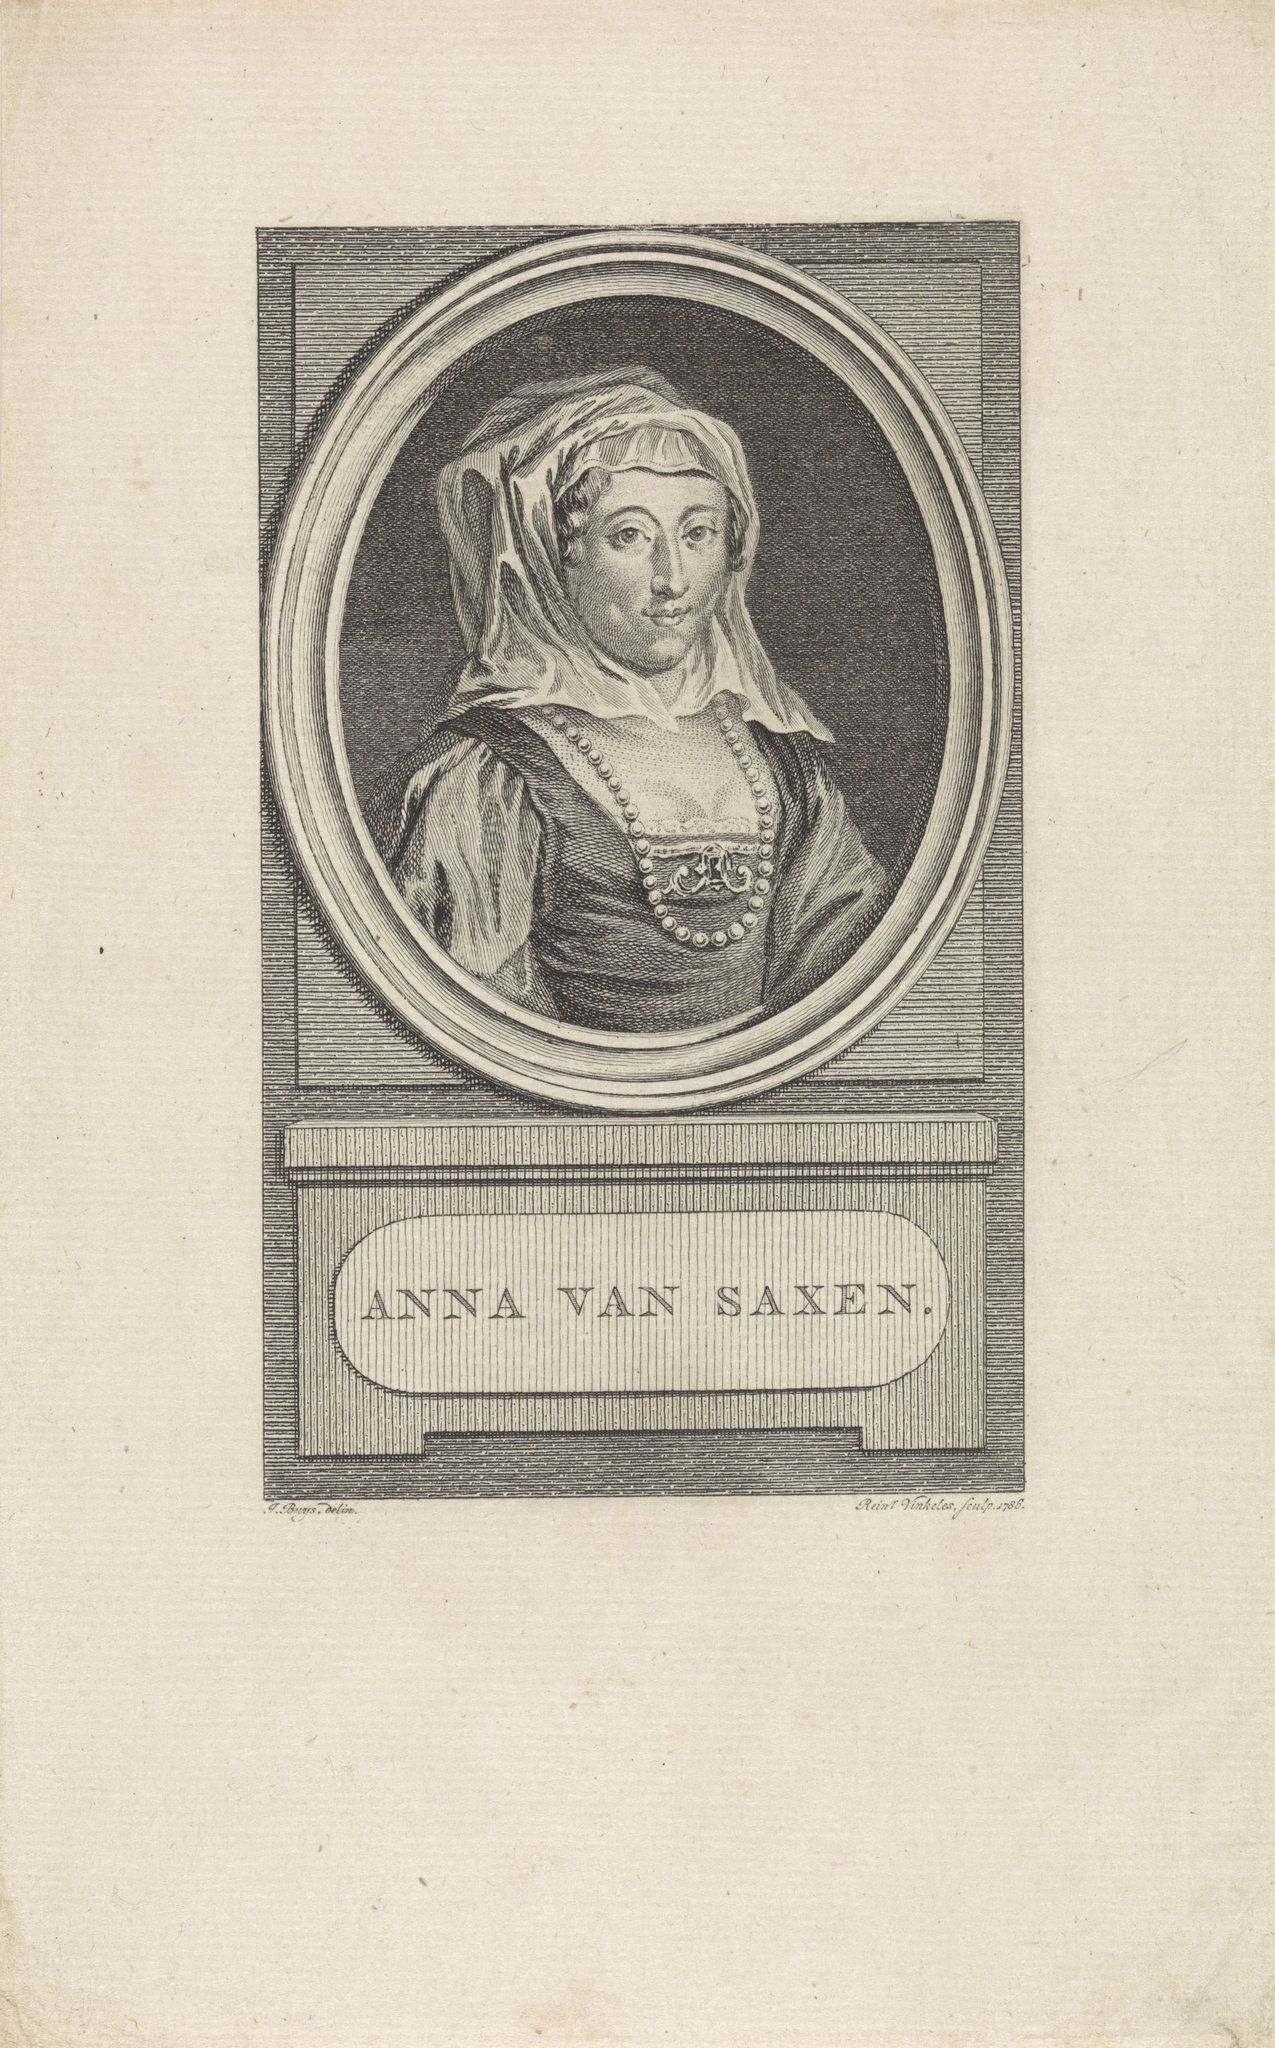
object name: print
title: Portret van Anna van Saksen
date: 1786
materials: paper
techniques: engraving, etching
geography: amsterdam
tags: dresden, anna van saksen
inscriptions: collector's mark: Lugt 2228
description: Andere staat prent gebruikt als boekillustratie in: Kok, Jacobus. Vaderlandsch woordenboek : met kaarten, plaaten en pourtraitten. Amsterdam: Johannes Allart, 1785-1796. Deel IV.